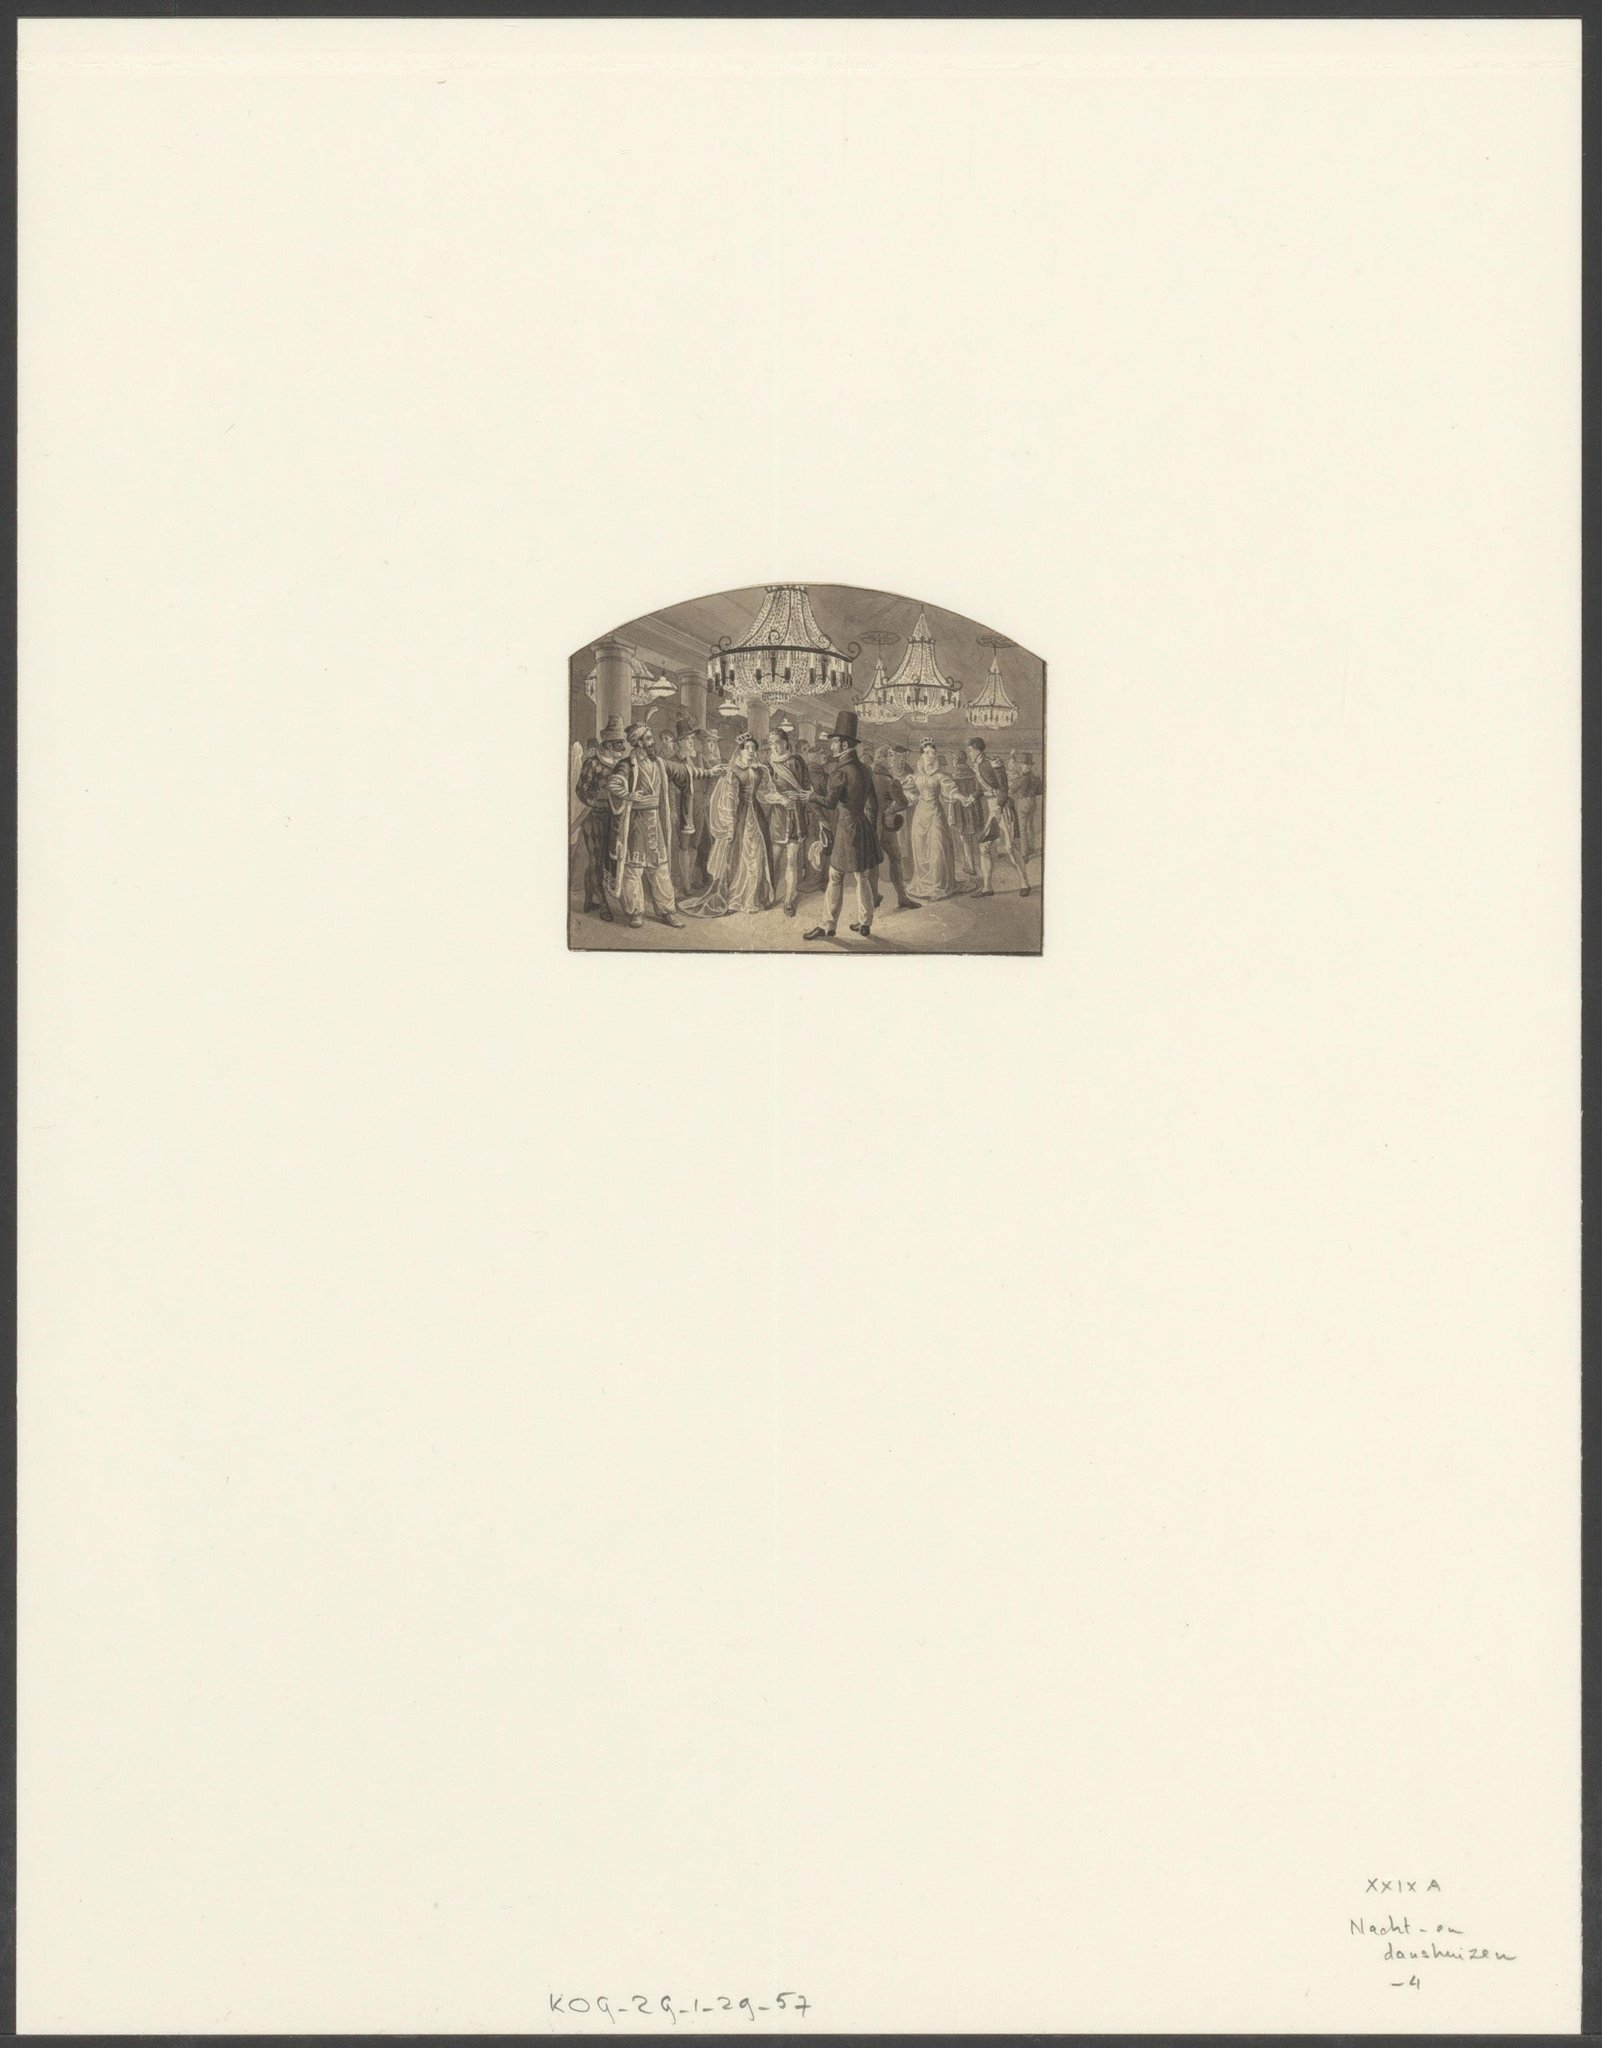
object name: drawing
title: Gezelschap in een danszaal met grote kroonluchters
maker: Anonymous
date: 1750-1849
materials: ink, paper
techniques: brush, pen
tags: night-club, dance-hall, ball, formal dance, inn, coffee-house, public house, etc., group dancing, amsterdam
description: Gezelschap in een danszaal met grote kroonluchters in het speelhuis de Pijl. Speelhuis De Pijl was het voornaamste speelhuis van Amsterdam. Onderwerpsrubrieken binnen de Atlas Zeden en Gewoonten: Zeden en gewoonten in engeren zin, Volksleven, Uitspanningslokalen, Nacht- en danshuizen.